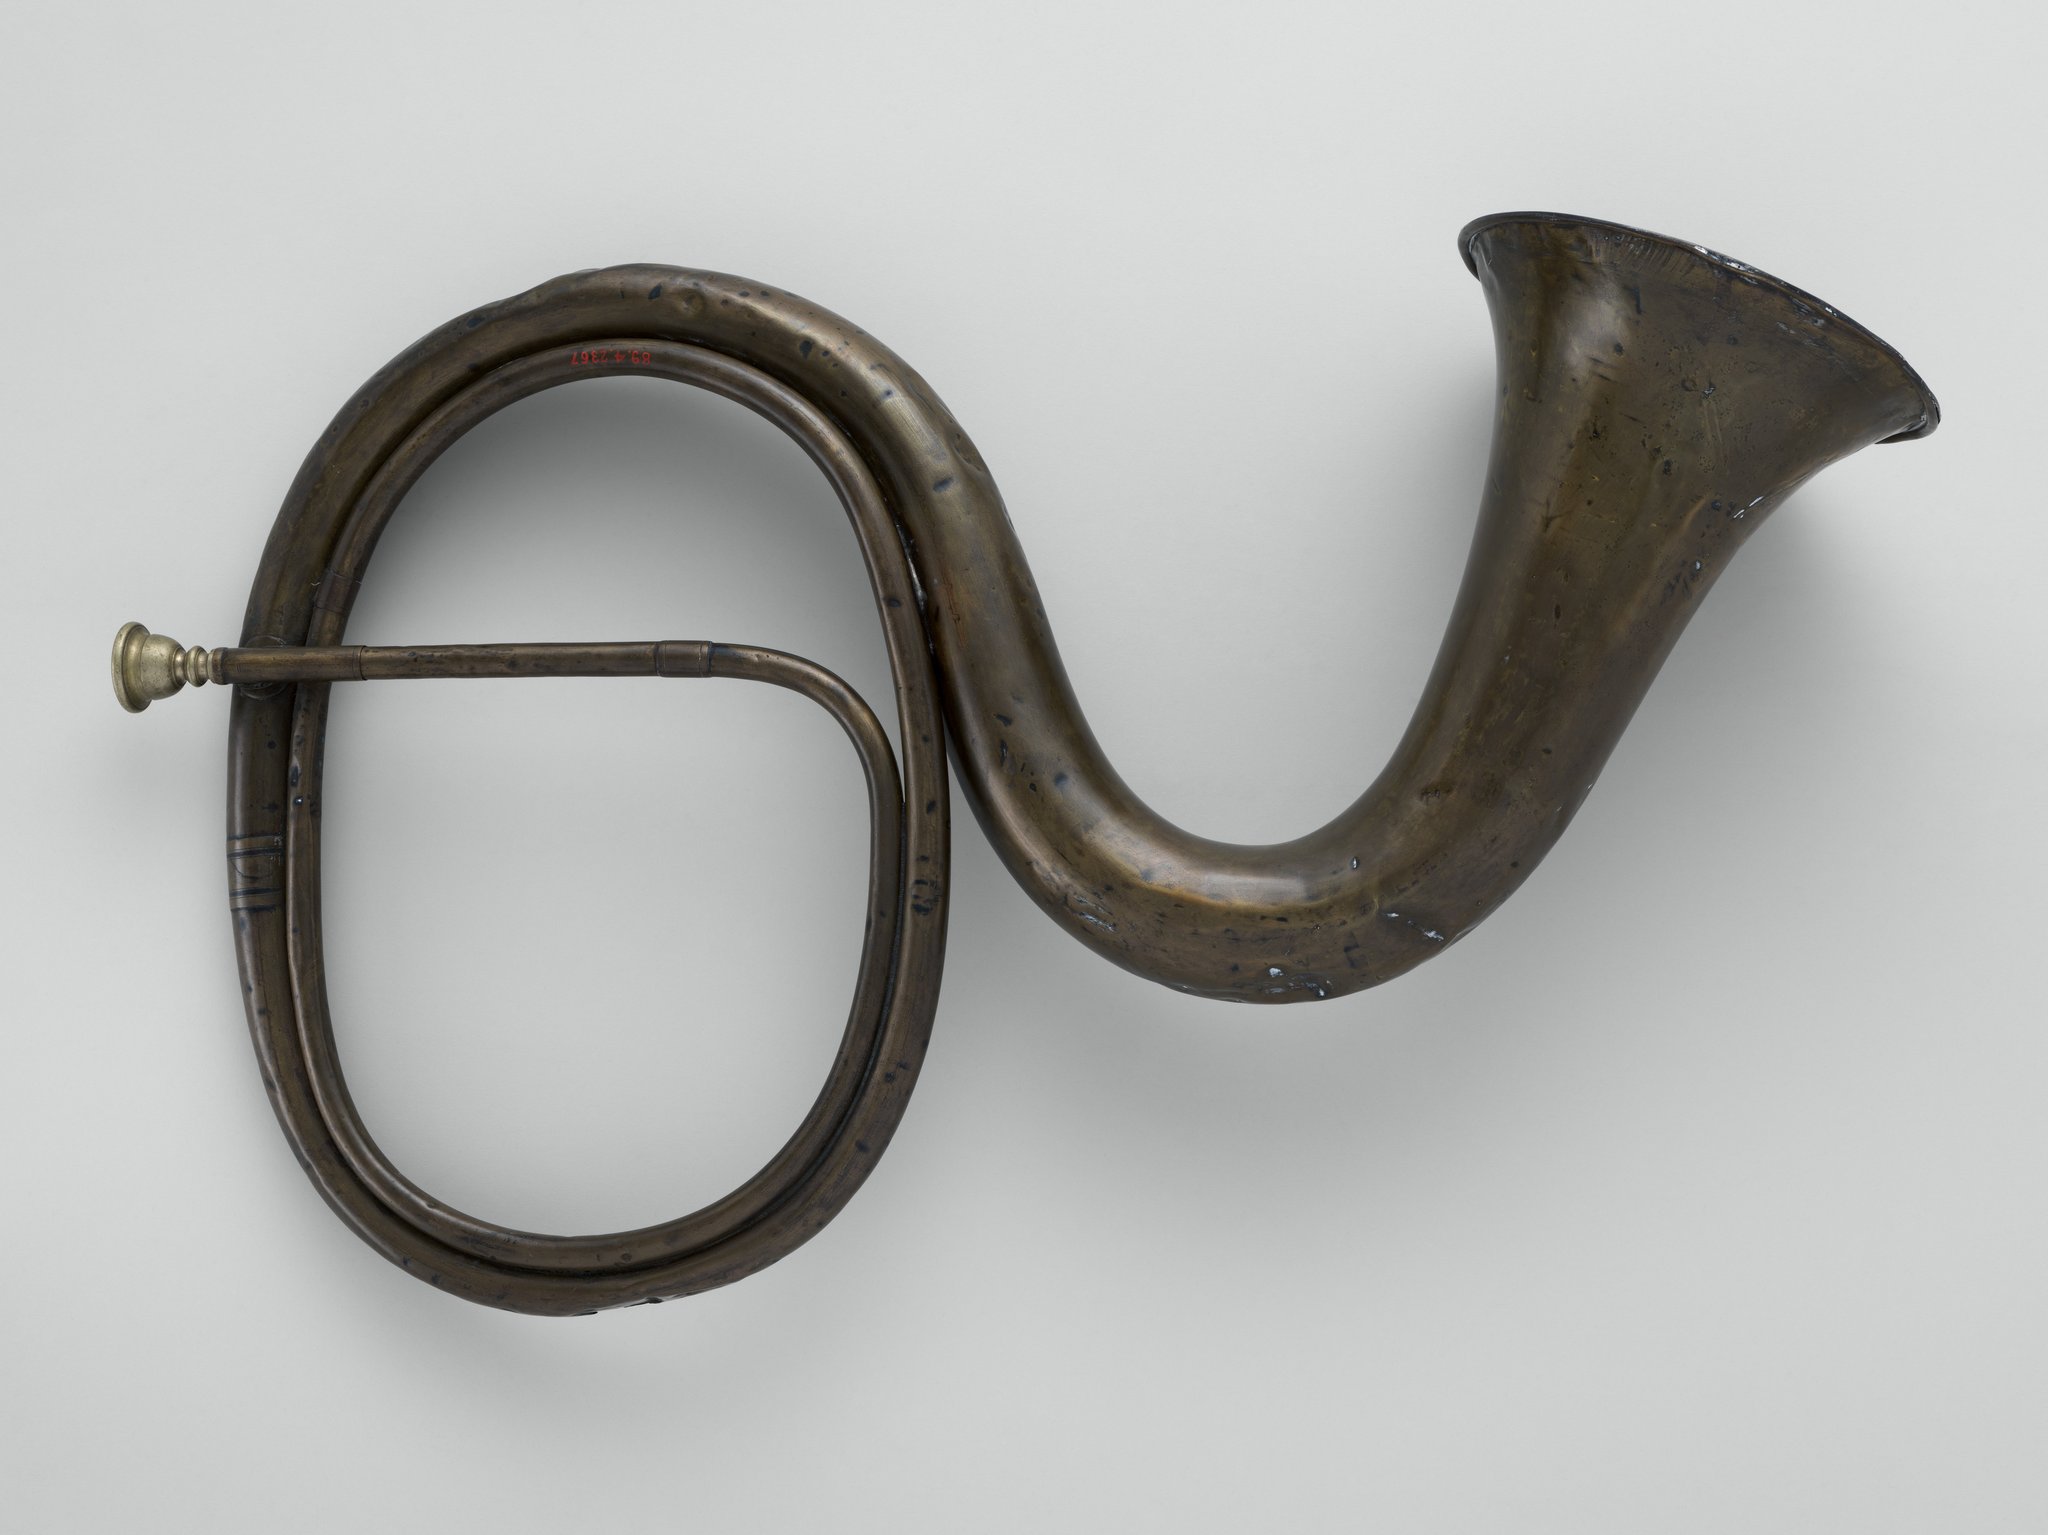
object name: basso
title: "Basso"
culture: italian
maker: leopoldo franciolini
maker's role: maker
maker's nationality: italian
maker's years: 1844-1920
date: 1851-1900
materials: brass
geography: italy